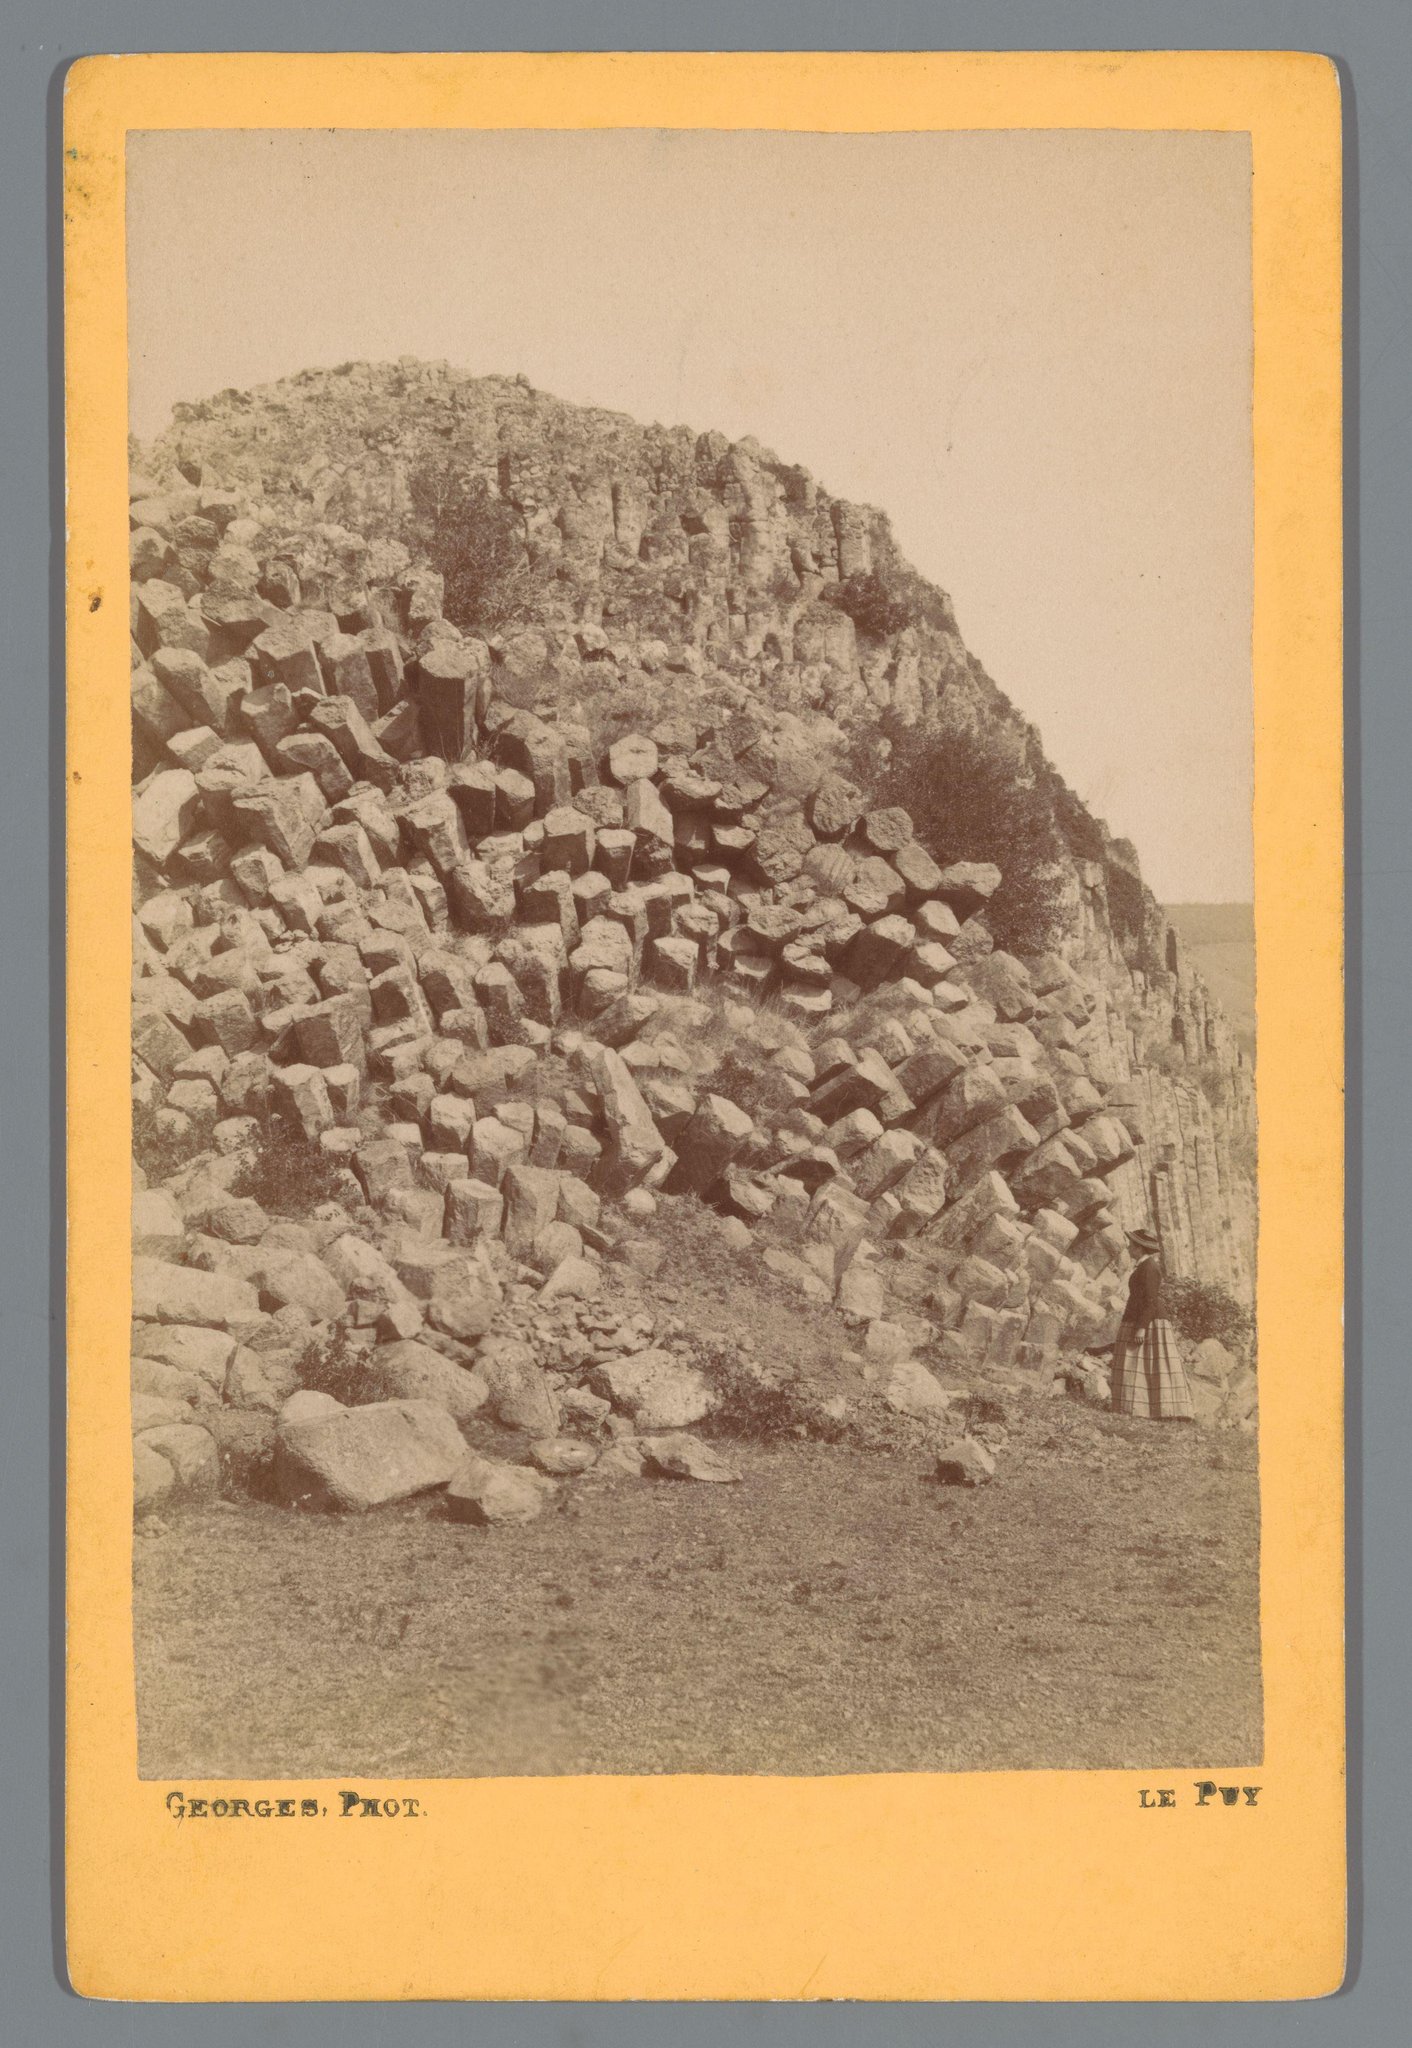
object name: cabinet photograph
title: Rotsformatie bij Le Puy-en-Velay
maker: a. georges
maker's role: fotograaf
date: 1870-1900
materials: cardboard, photographic support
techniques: albumen print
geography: le puy-en-velay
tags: rock-formations